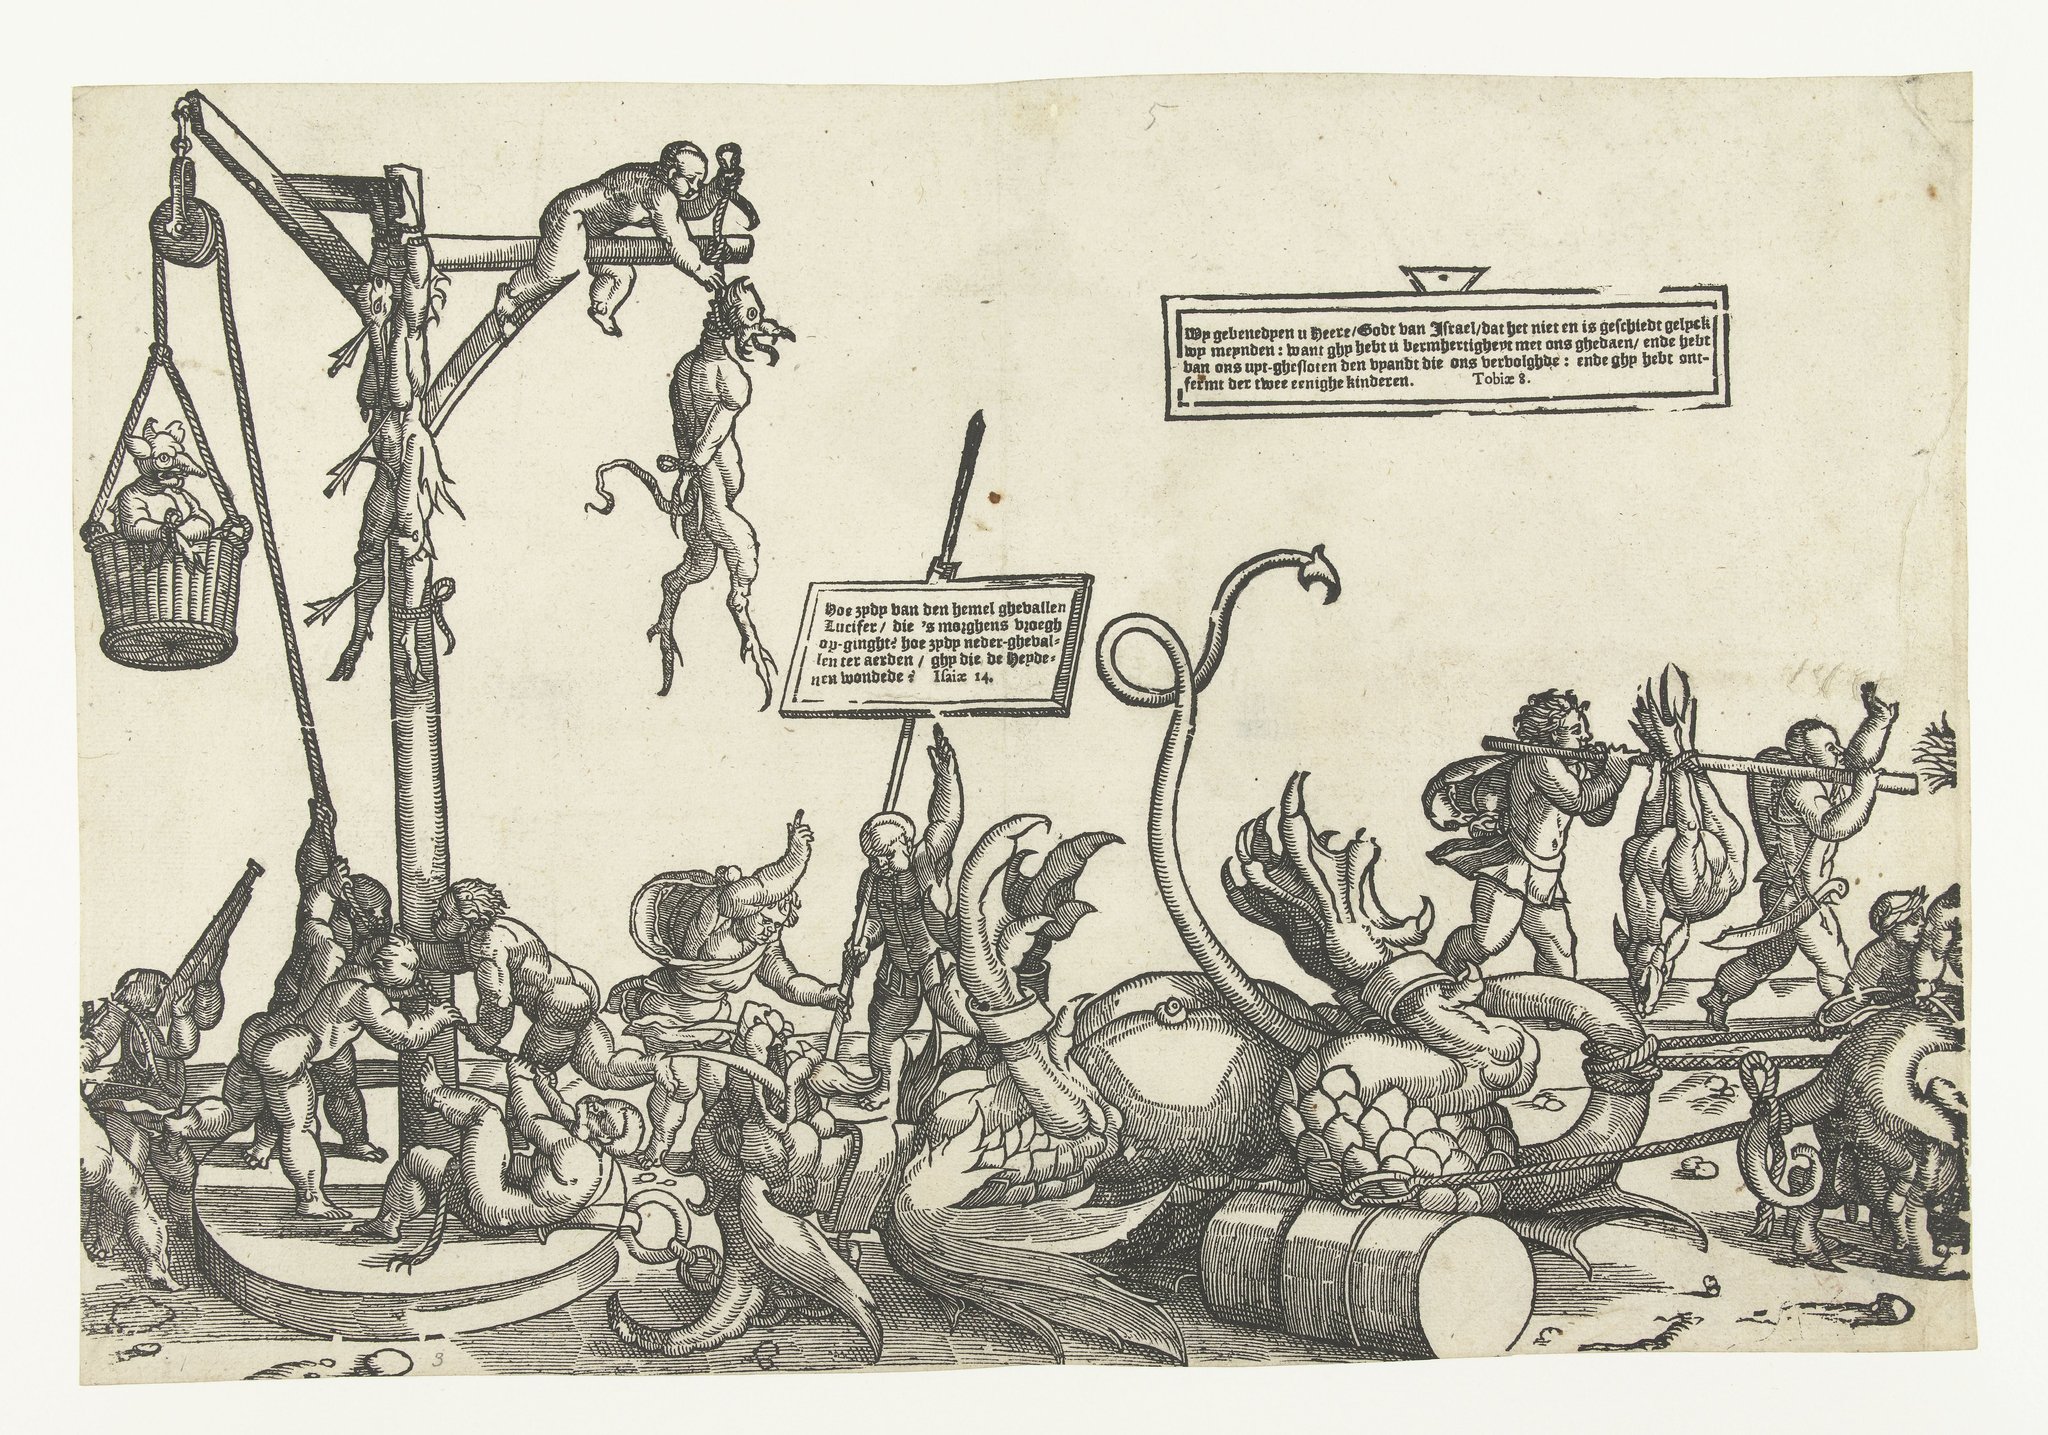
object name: print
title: Kinderkruistocht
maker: monogrammist liw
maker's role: print maker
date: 1522-1532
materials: paper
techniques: woodcut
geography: low countries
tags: child, christian religion (+ devil(s)), militant proselytizing: religious war, crusade, etc., law and jurisprudence (+ torture)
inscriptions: collector's mark: Lugt 240, collector's mark: Lugt 2166, collector's mark: Lugt 2166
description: Vierde blok van zes, vormen samen een fries met de kinderkruistocht. Duivels worden gedood en gemarteld door kinderen. Twee cartouches met tekst in het Nederlands.